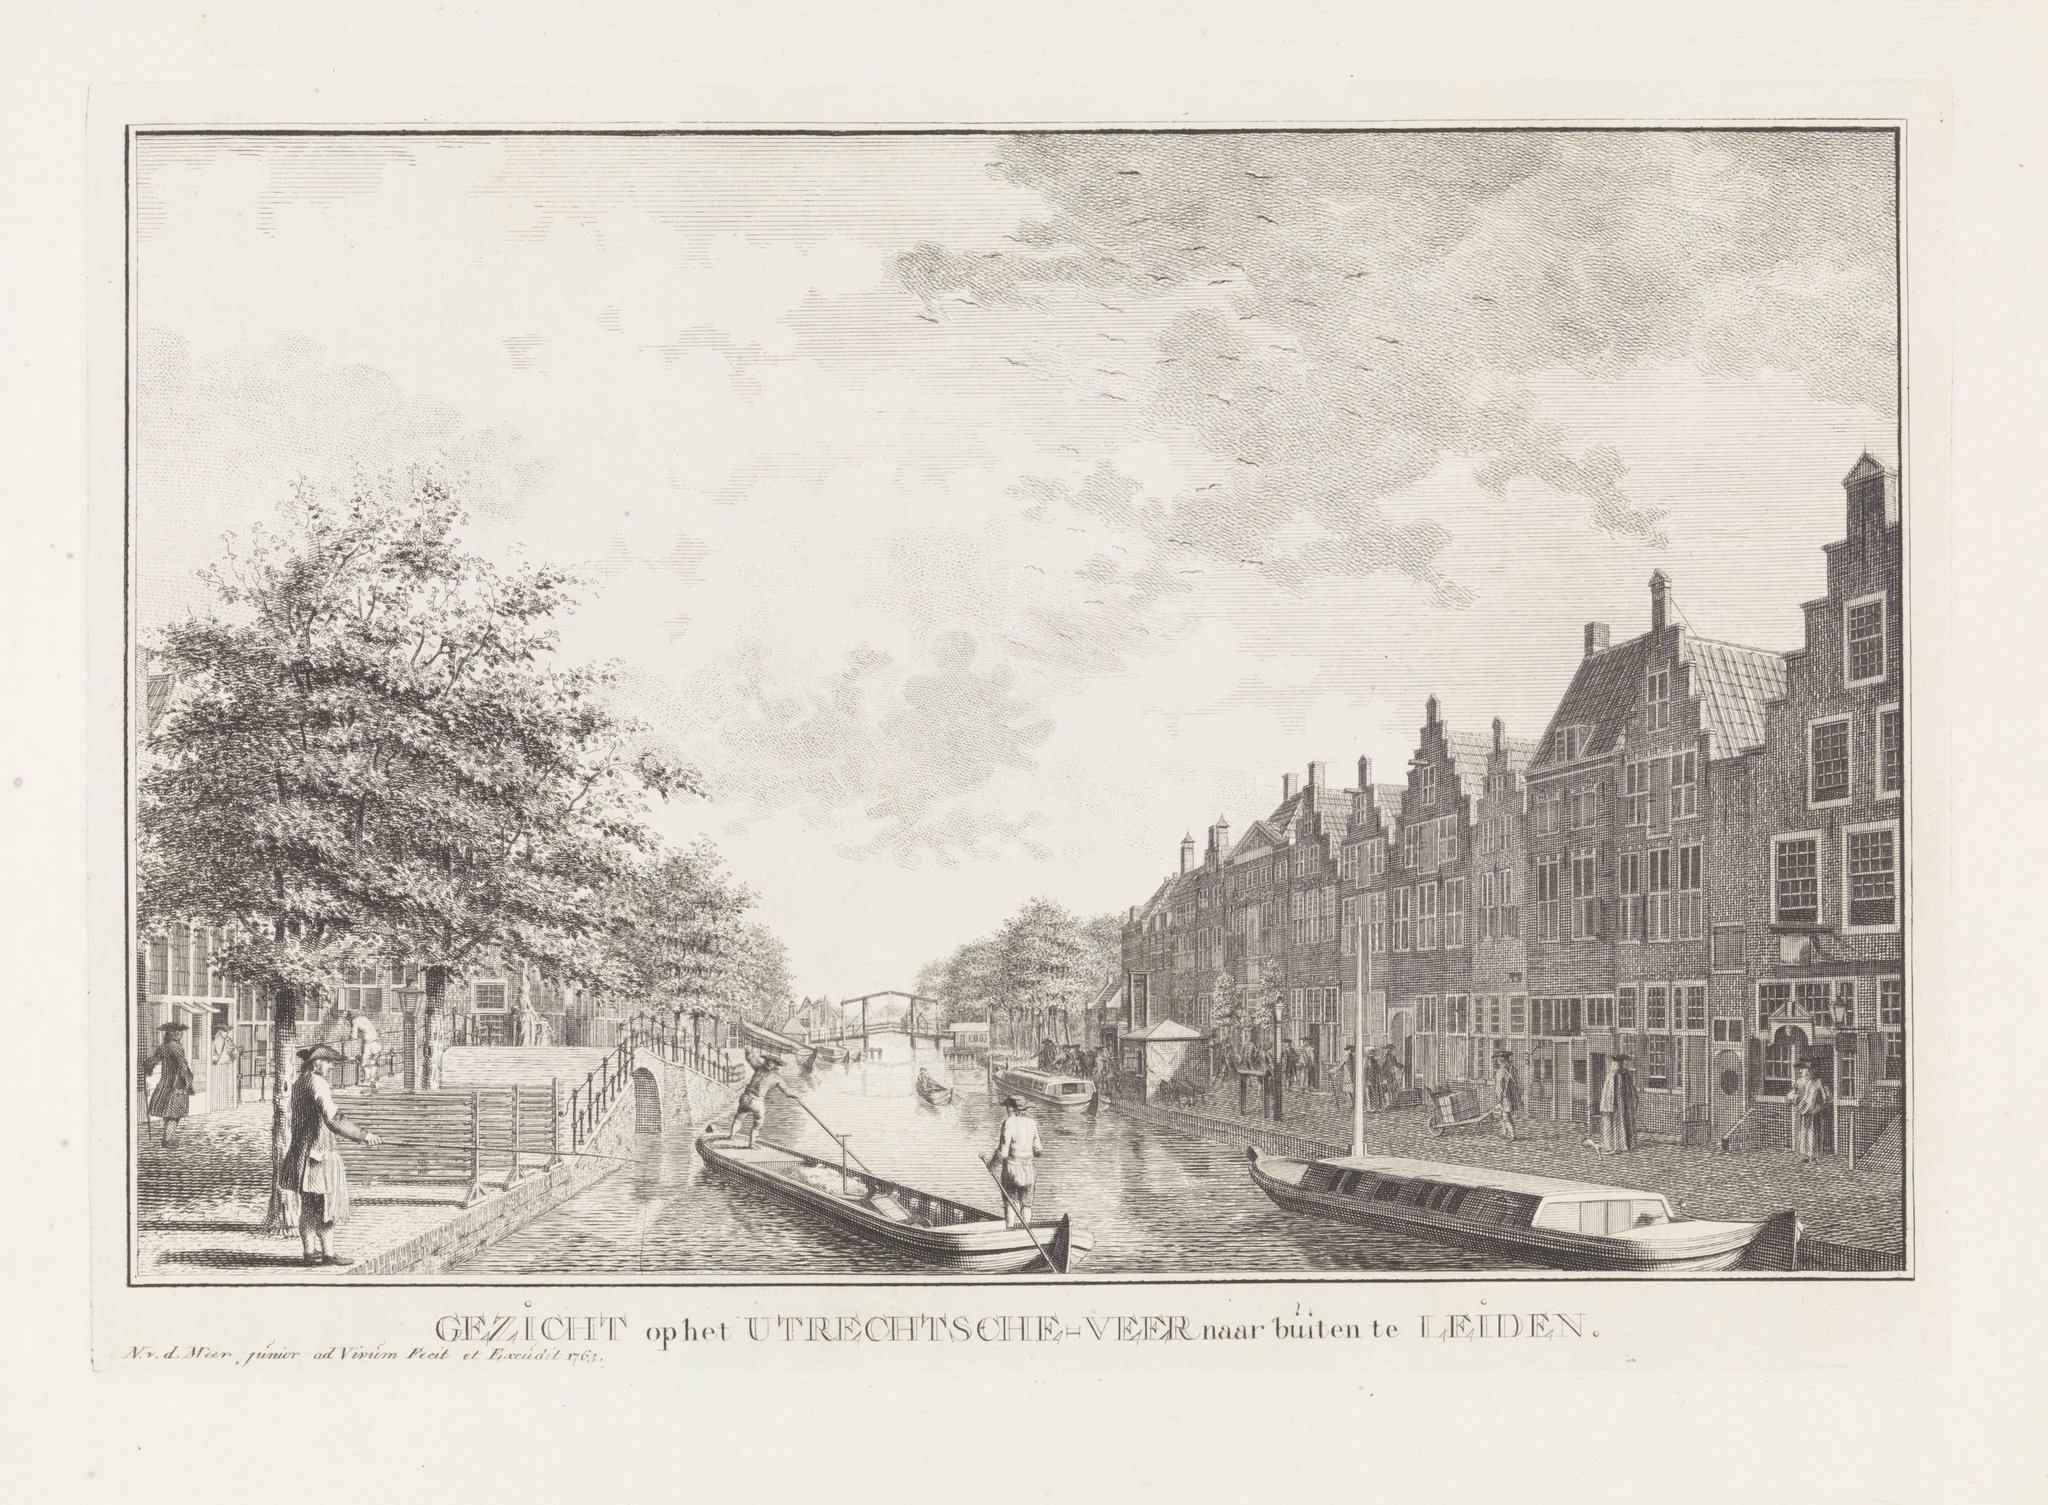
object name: print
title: Gezicht op het Utrechtse Veer te Leiden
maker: noach van der meer (ii)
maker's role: draughtsman, print maker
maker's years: 1741-1822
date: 1763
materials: paper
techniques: engraving, etching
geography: leiden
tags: ferry (+ departure and arrival ~ traffic and transport), poling, punting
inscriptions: collector's mark: Lugt 2228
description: Gezicht op het Utrechtse Veer langs de Nieuwe Rijn te Leiden. Rechts liggen twee veerboten en op de kade staat een wachthuisje voor het veer naar Utrecht. Op de voorgrond twee mannen op een schuit.